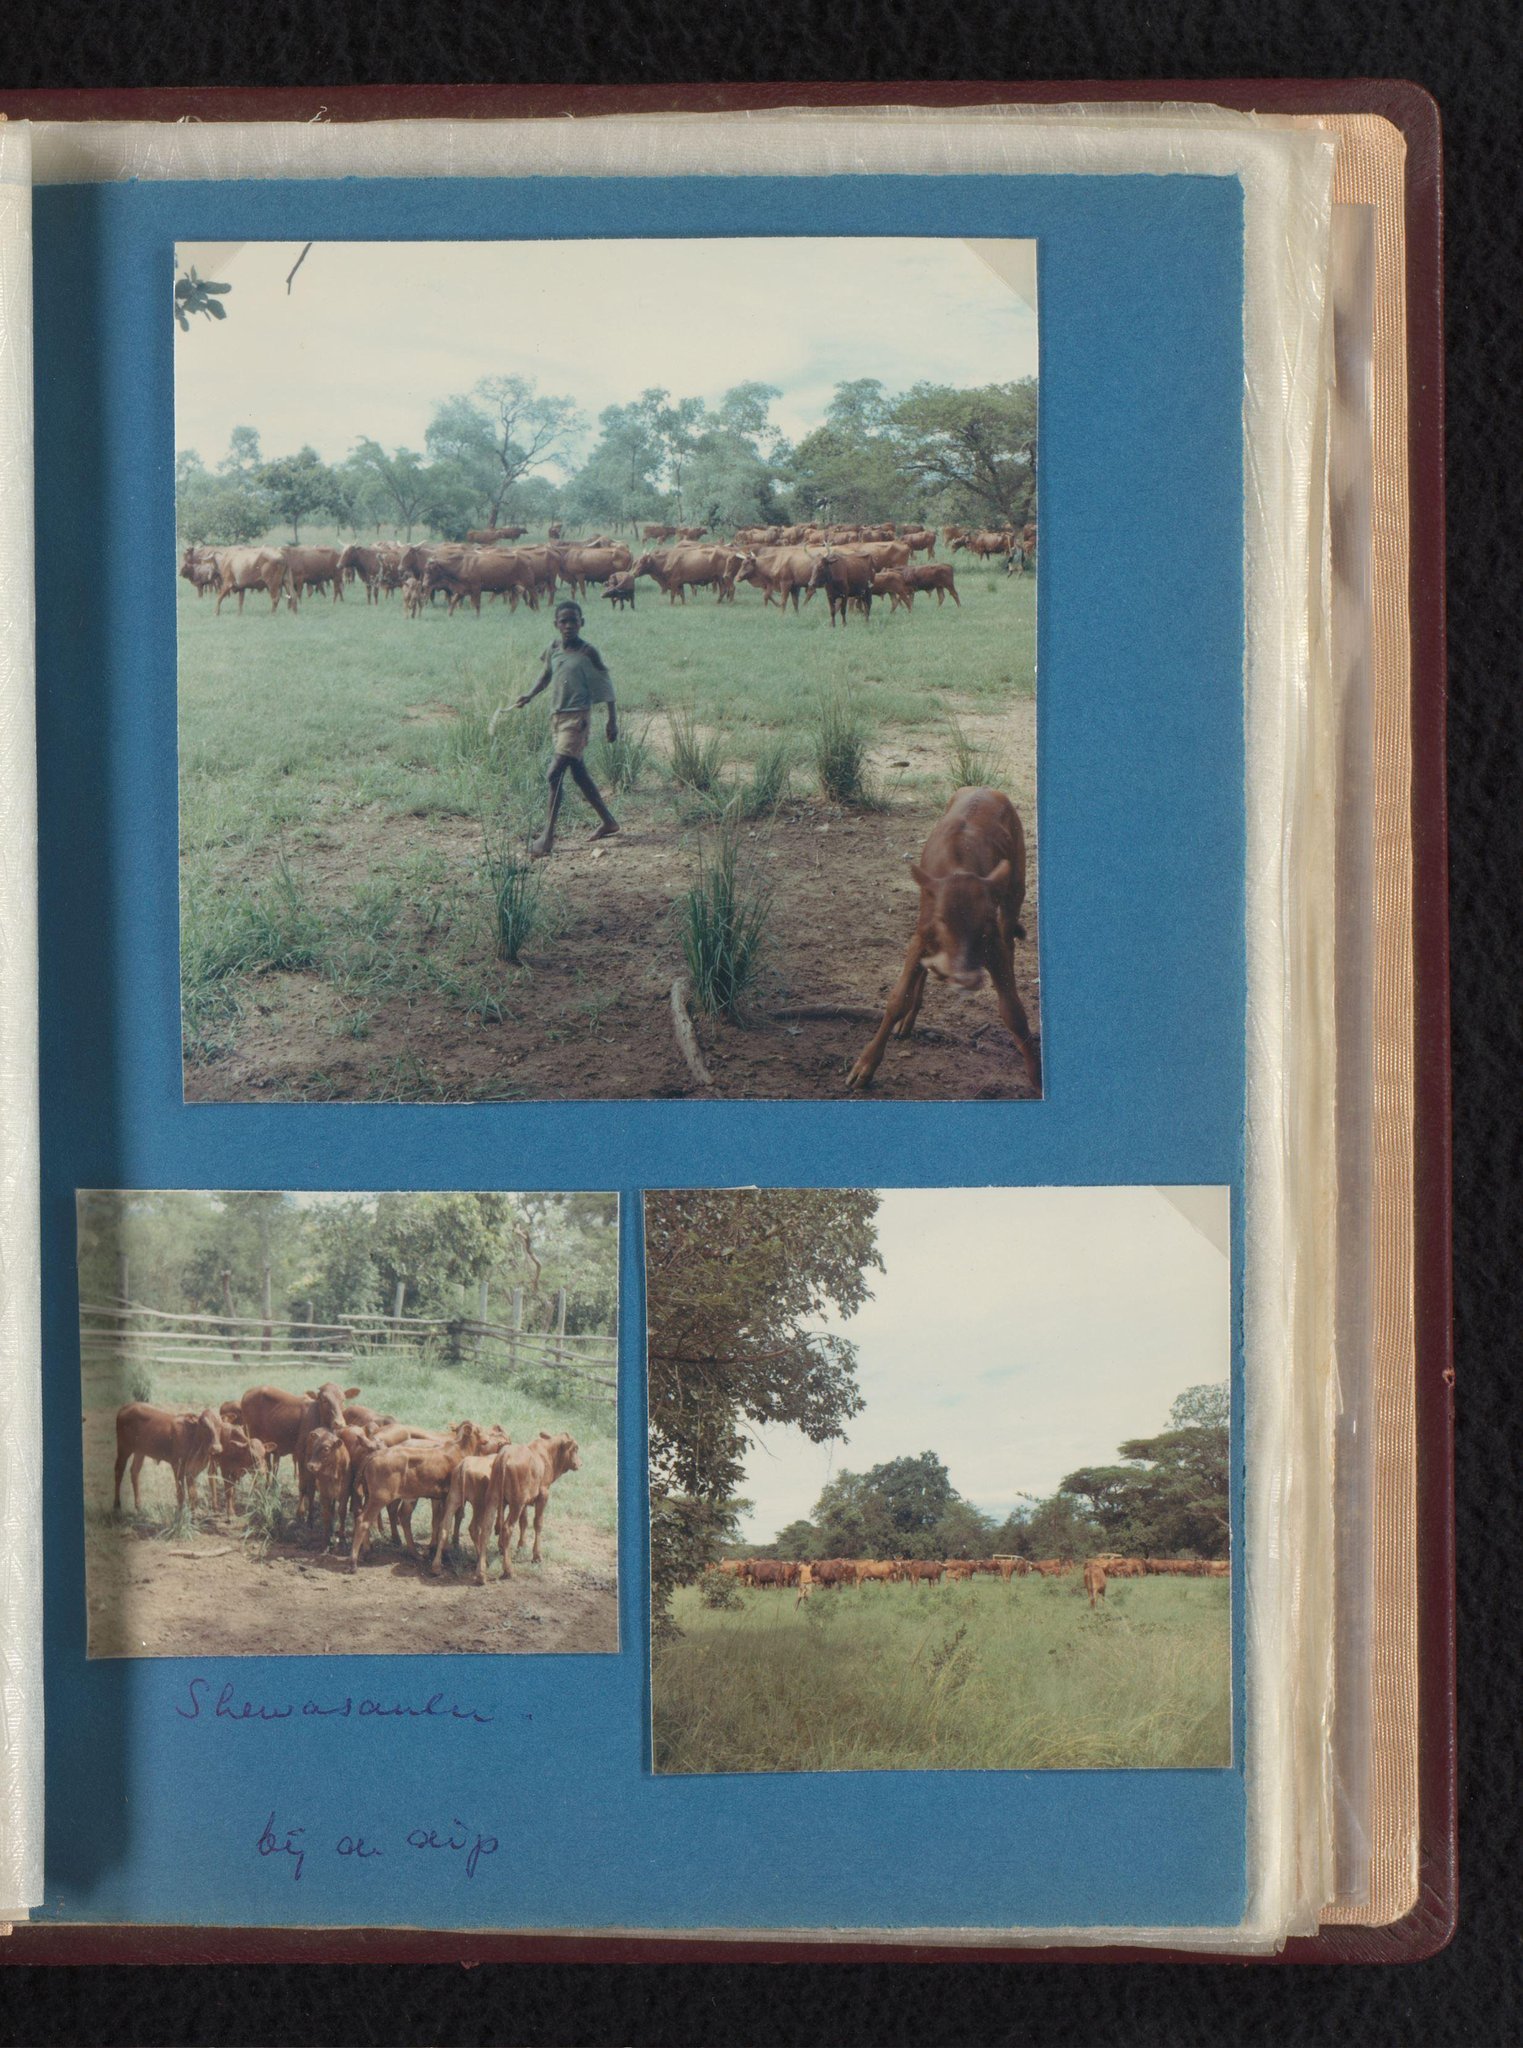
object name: album leaf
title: Kudde Afrikaner rundvee bij Shewasaulu, Zuid-Afrika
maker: willem jacob van den berg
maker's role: boer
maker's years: 1902-1983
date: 1967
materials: paper, cardboard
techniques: chromogenic print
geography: shewasaulu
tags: cattle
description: Deze foto's zijn onderdeel van een album.